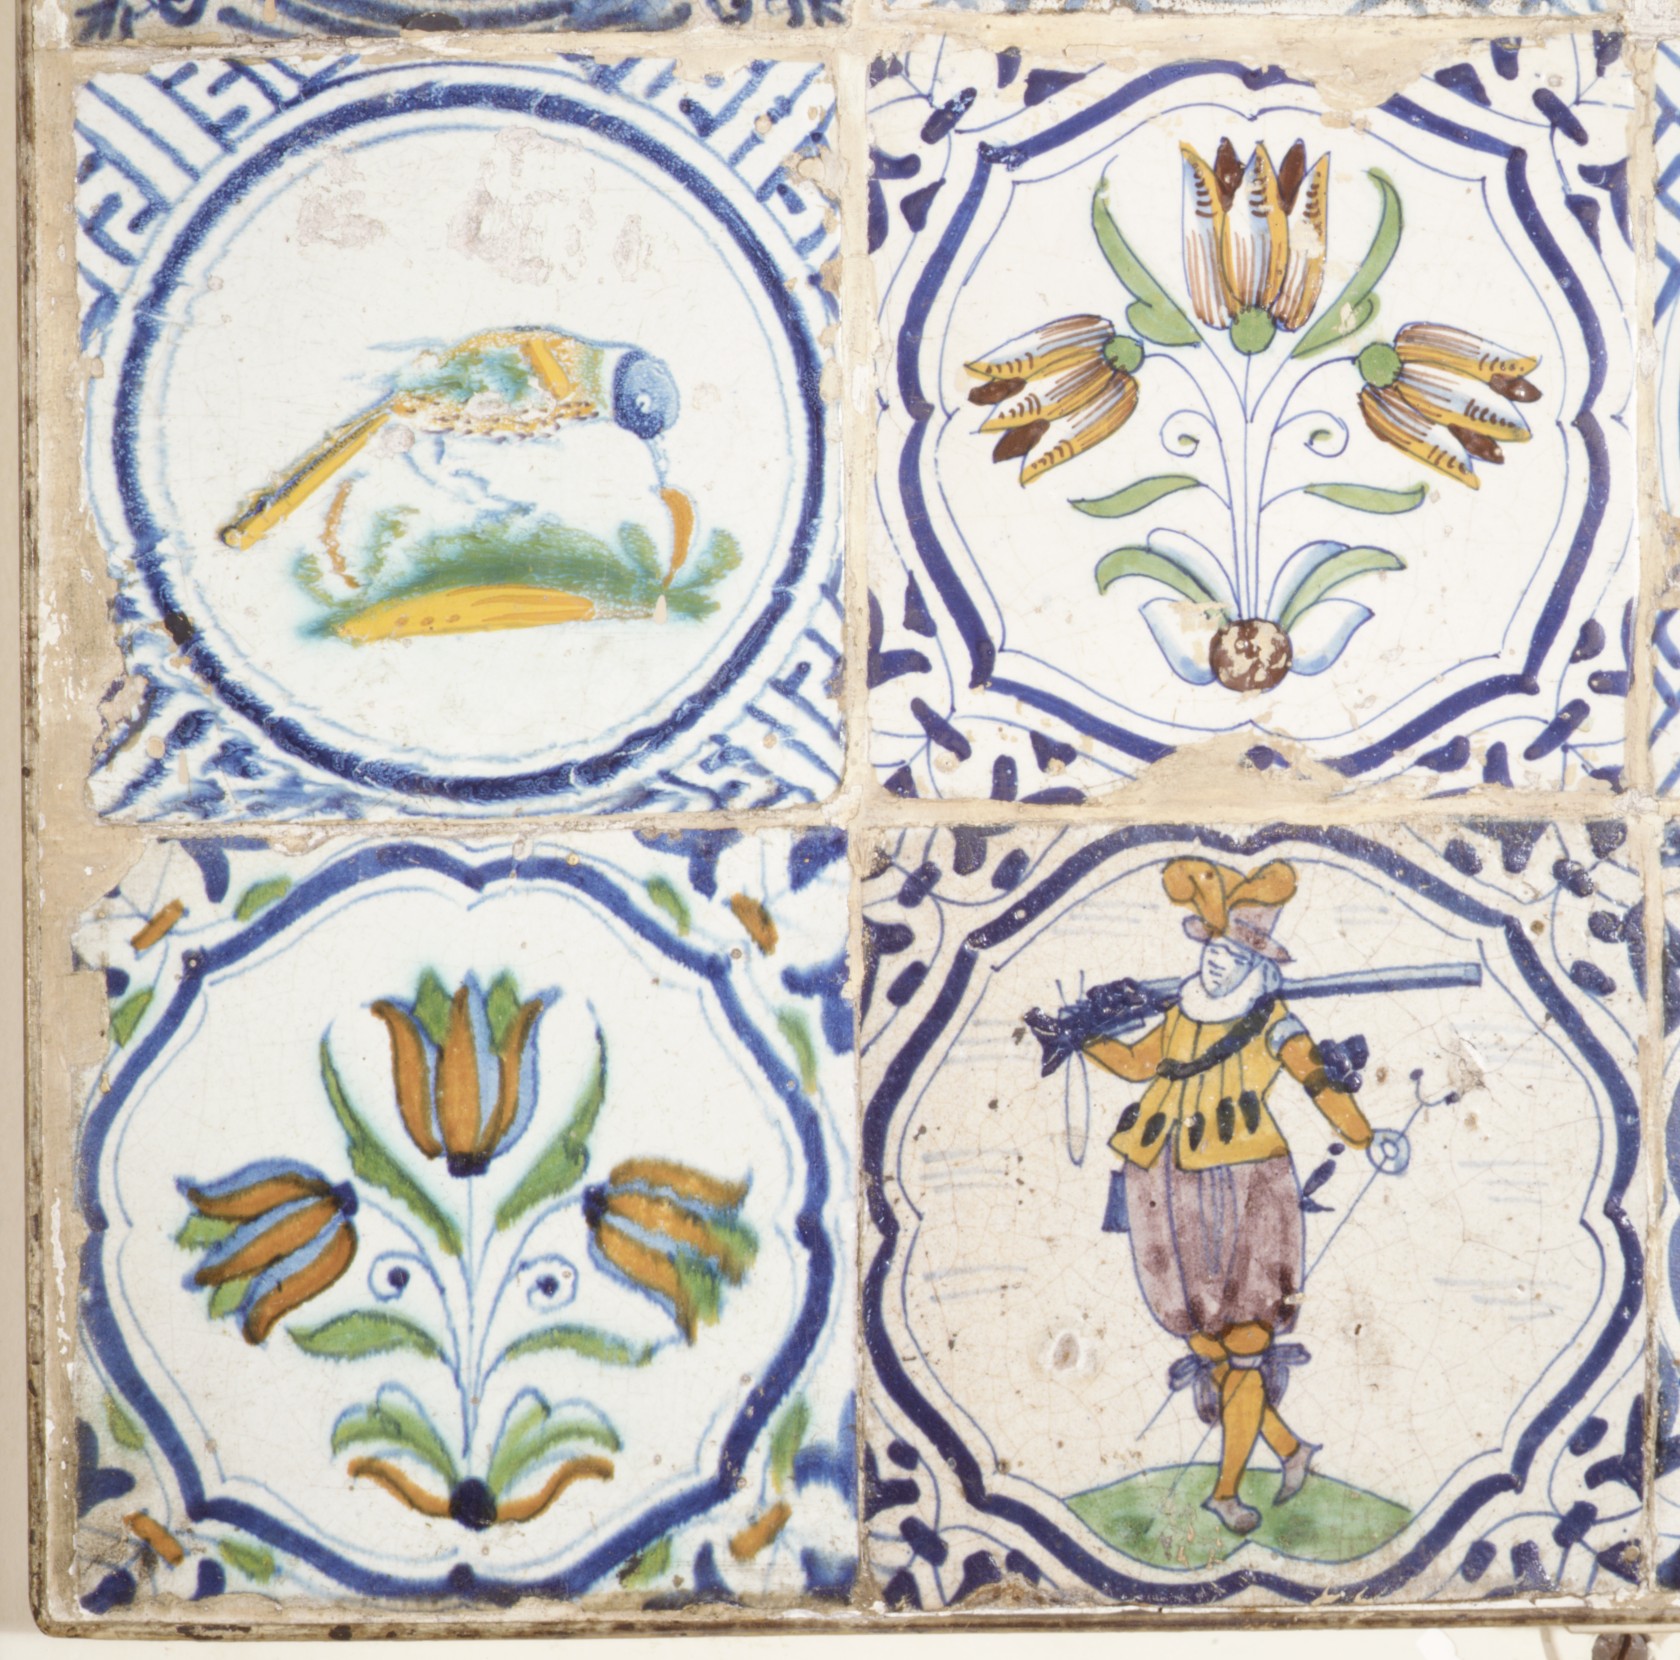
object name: tile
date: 1620-1640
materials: earthenware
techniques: glazing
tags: birds,men,flowers